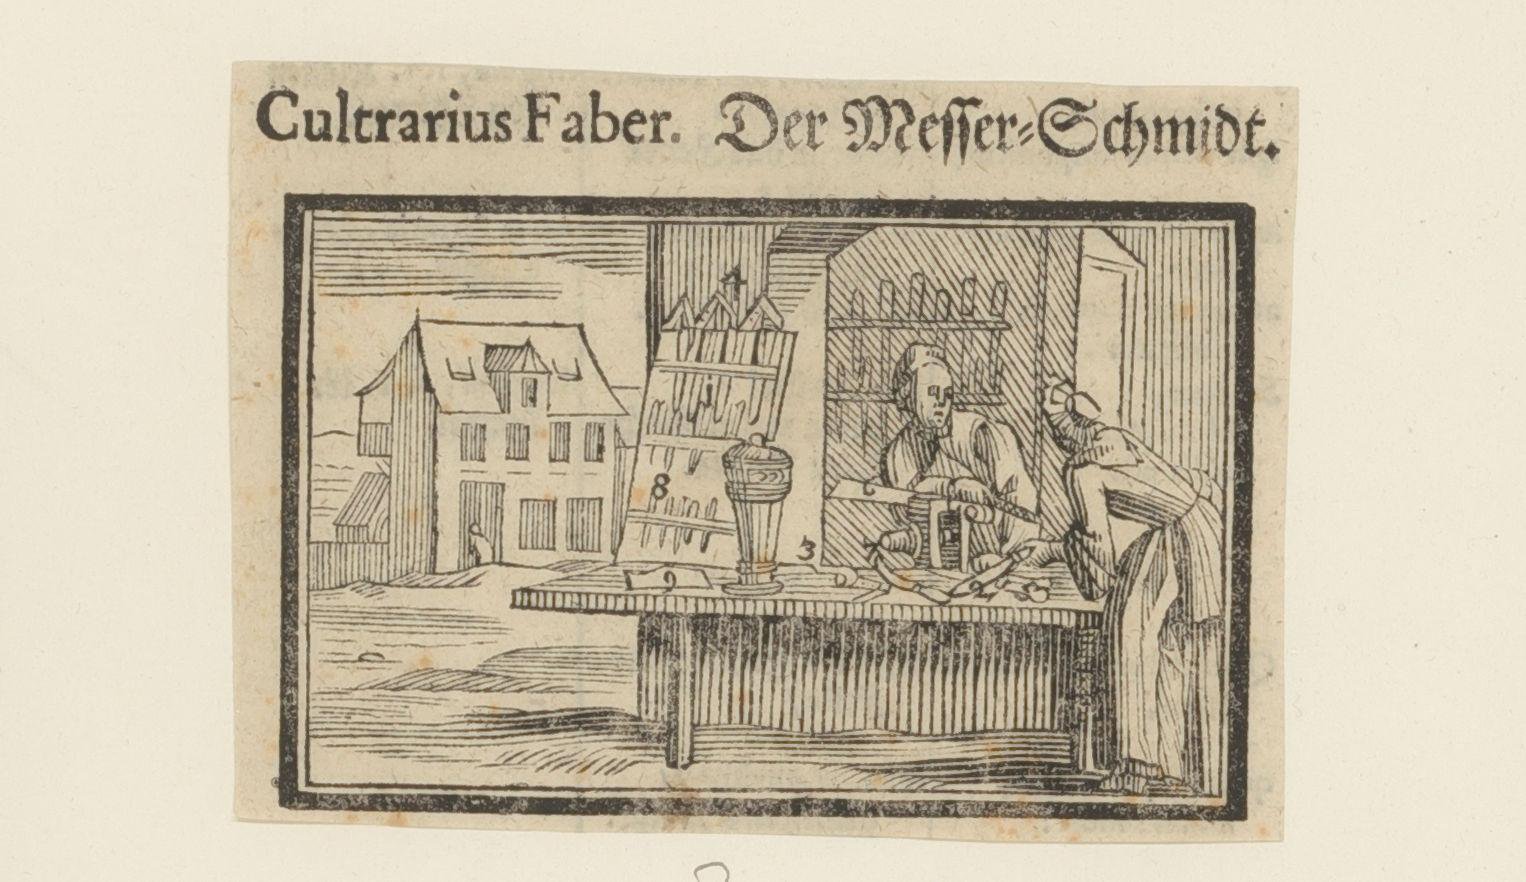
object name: print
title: Messensmid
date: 1719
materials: paper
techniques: letterpress printing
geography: nuremberg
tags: craft-production, skilled handiwork, handicrafts, craftsman at work, tools, aids, implements ~ crafts and industries: knife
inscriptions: collector's mark: Lugt 1641, stamp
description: Prent uit: Comenius, Johannes Amosius. Orbis sensualium picti pars prima (...). Neurenberg: Martin Endter, 1719, dl. 2,p. 142. Prent eerder gebruikt in: Comenius, Johannes Amosius. Orbis Sensualium Picti denuo aucti Pars Secunda (...). Neurenberg: Martin Endter, 1730, dl. 2.